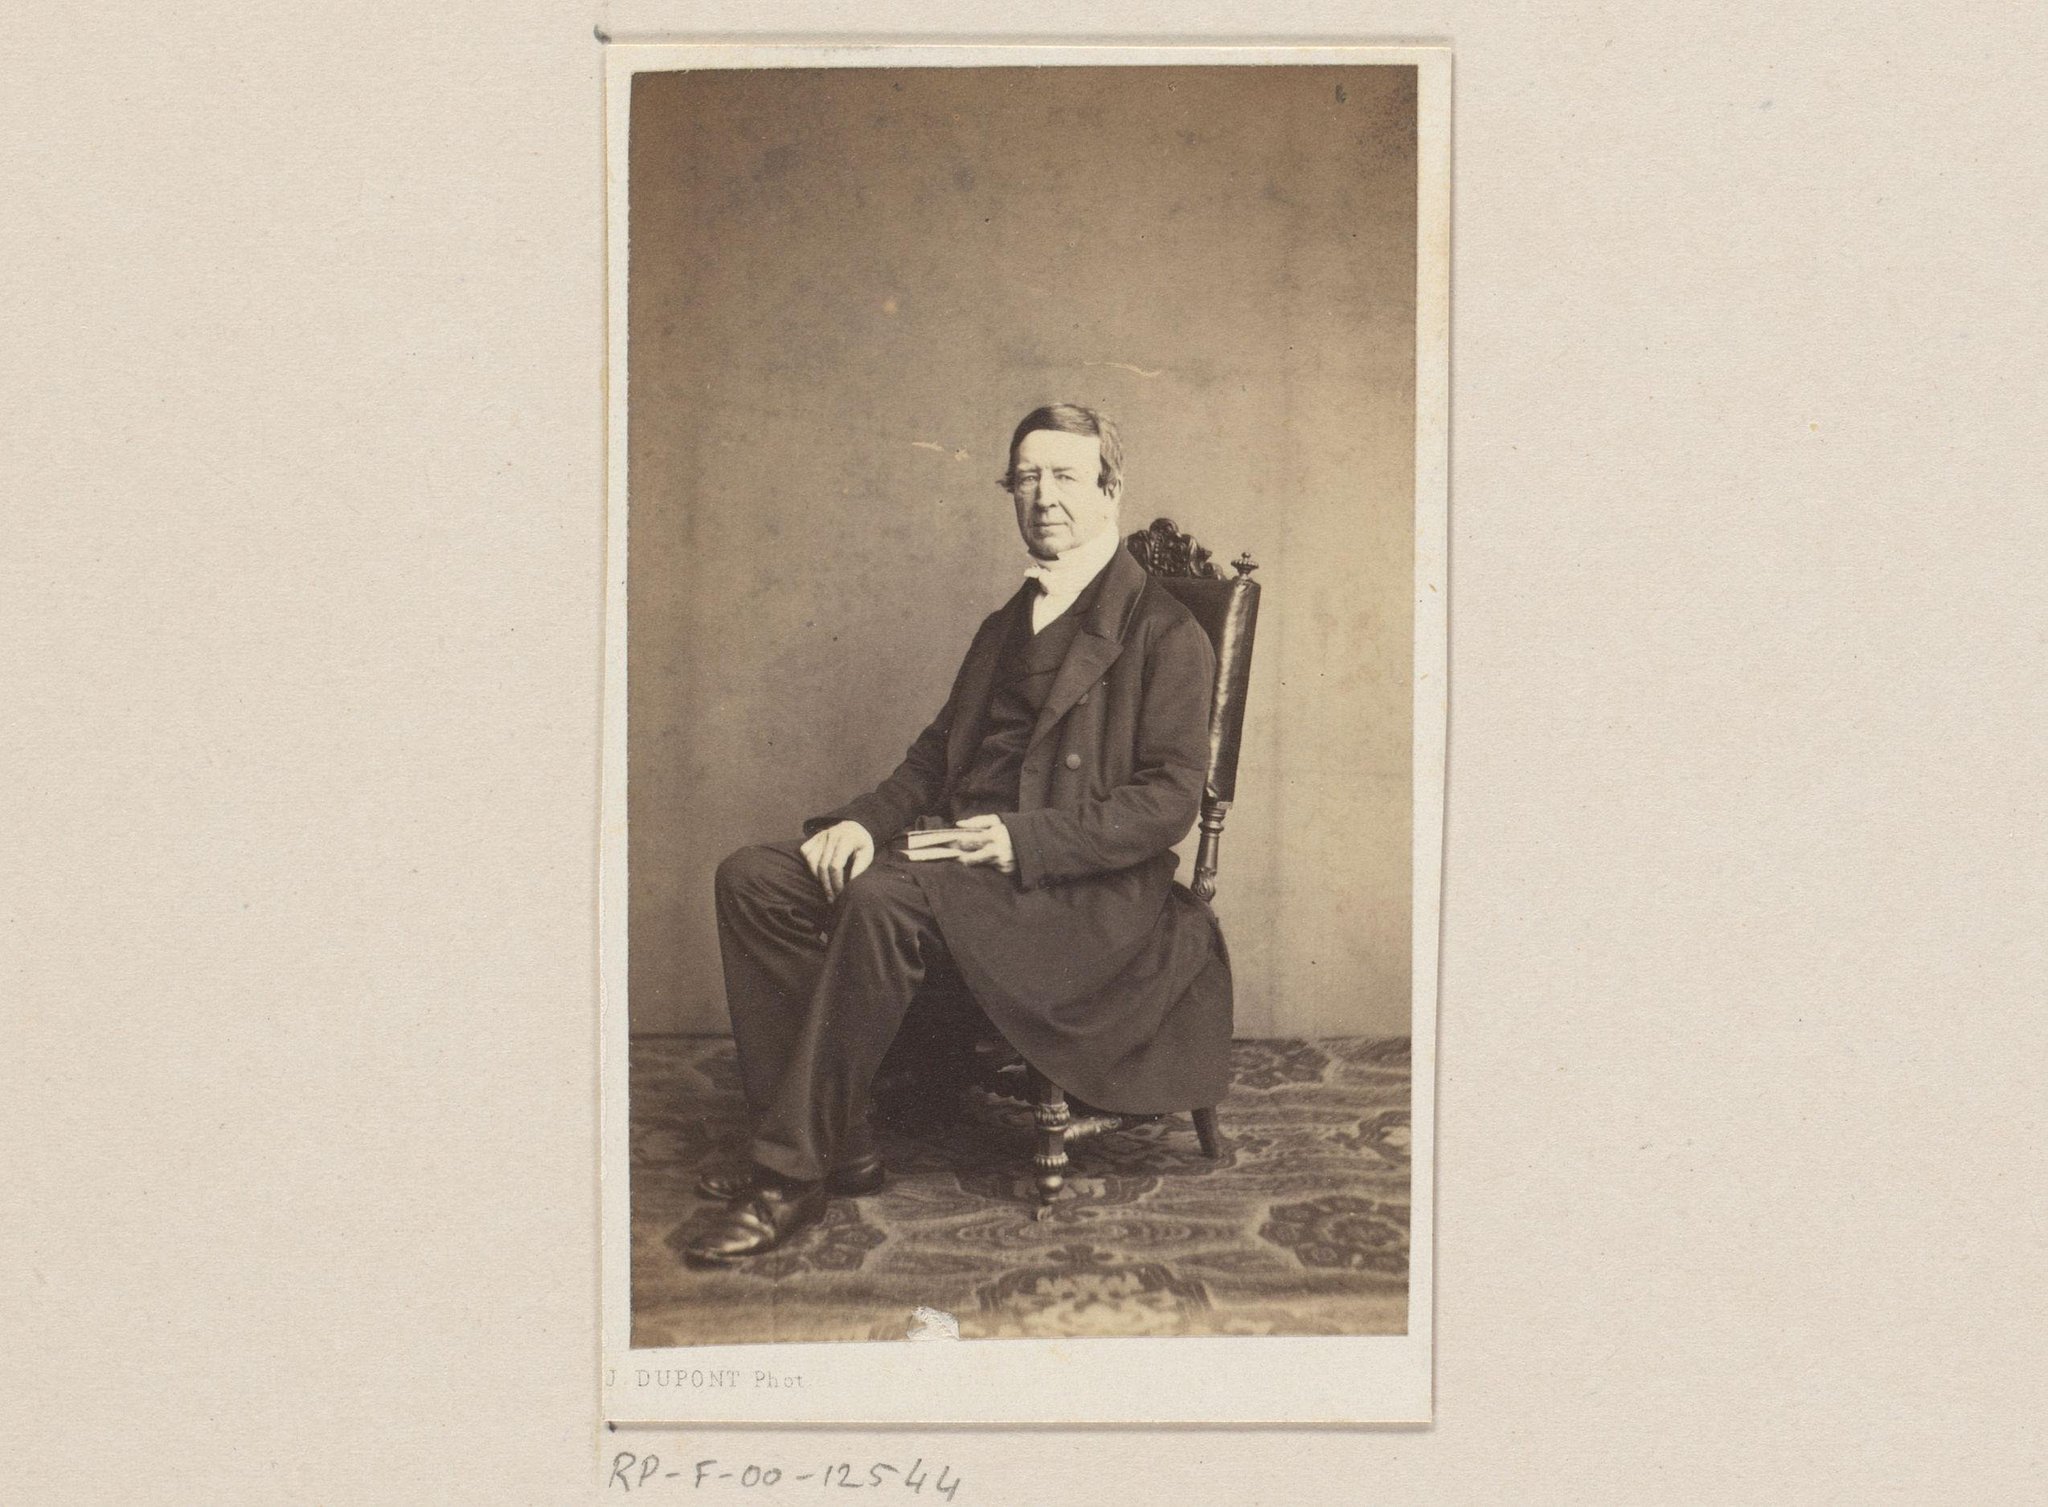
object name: photograph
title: Collection Dupont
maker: joseph dupont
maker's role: fotograaf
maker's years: 1818-1901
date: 1859-1873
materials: cardboard, paper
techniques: albumen print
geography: antwerp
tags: print maker, draughtsman, hendrik jozef franciscus van der poorten, historical persons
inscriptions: address: ‘Place de Meir, 32,/ ANVERS’